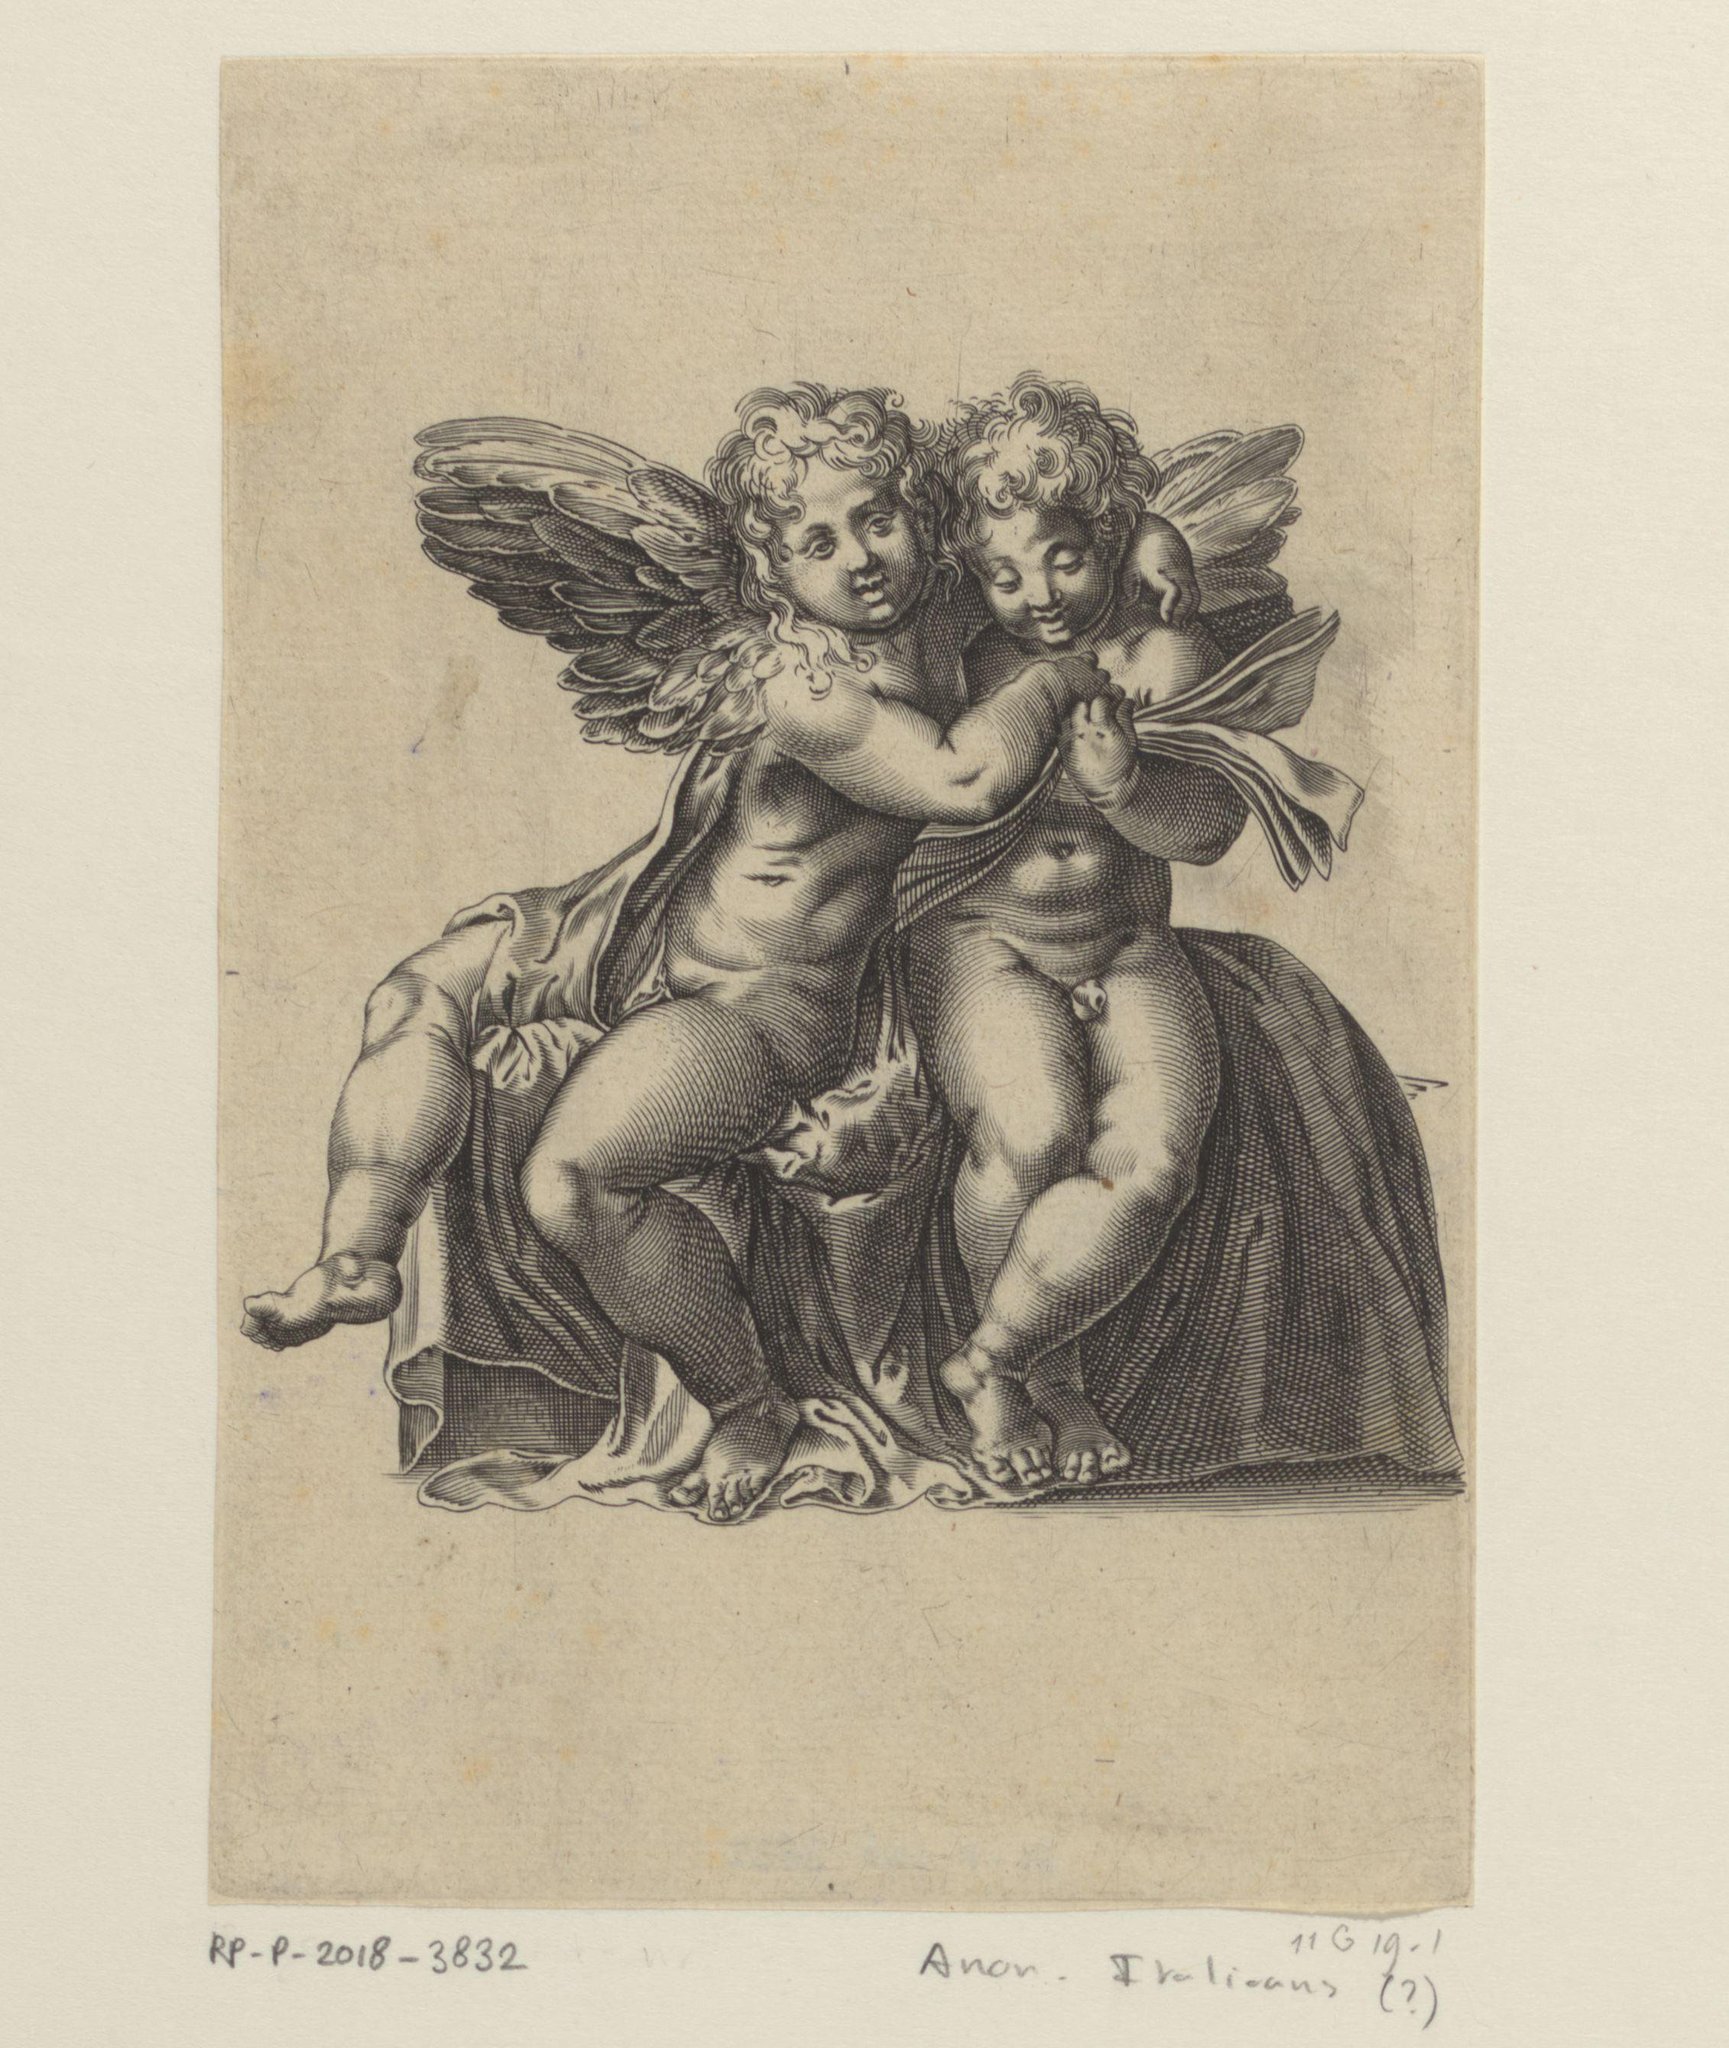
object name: print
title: Twee zingende, omhelzende engelen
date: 1583-1650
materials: paper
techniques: engraving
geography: italy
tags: angels singing, making music, angel(s) represented as child(ren)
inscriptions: collector's mark: Lugt 2228